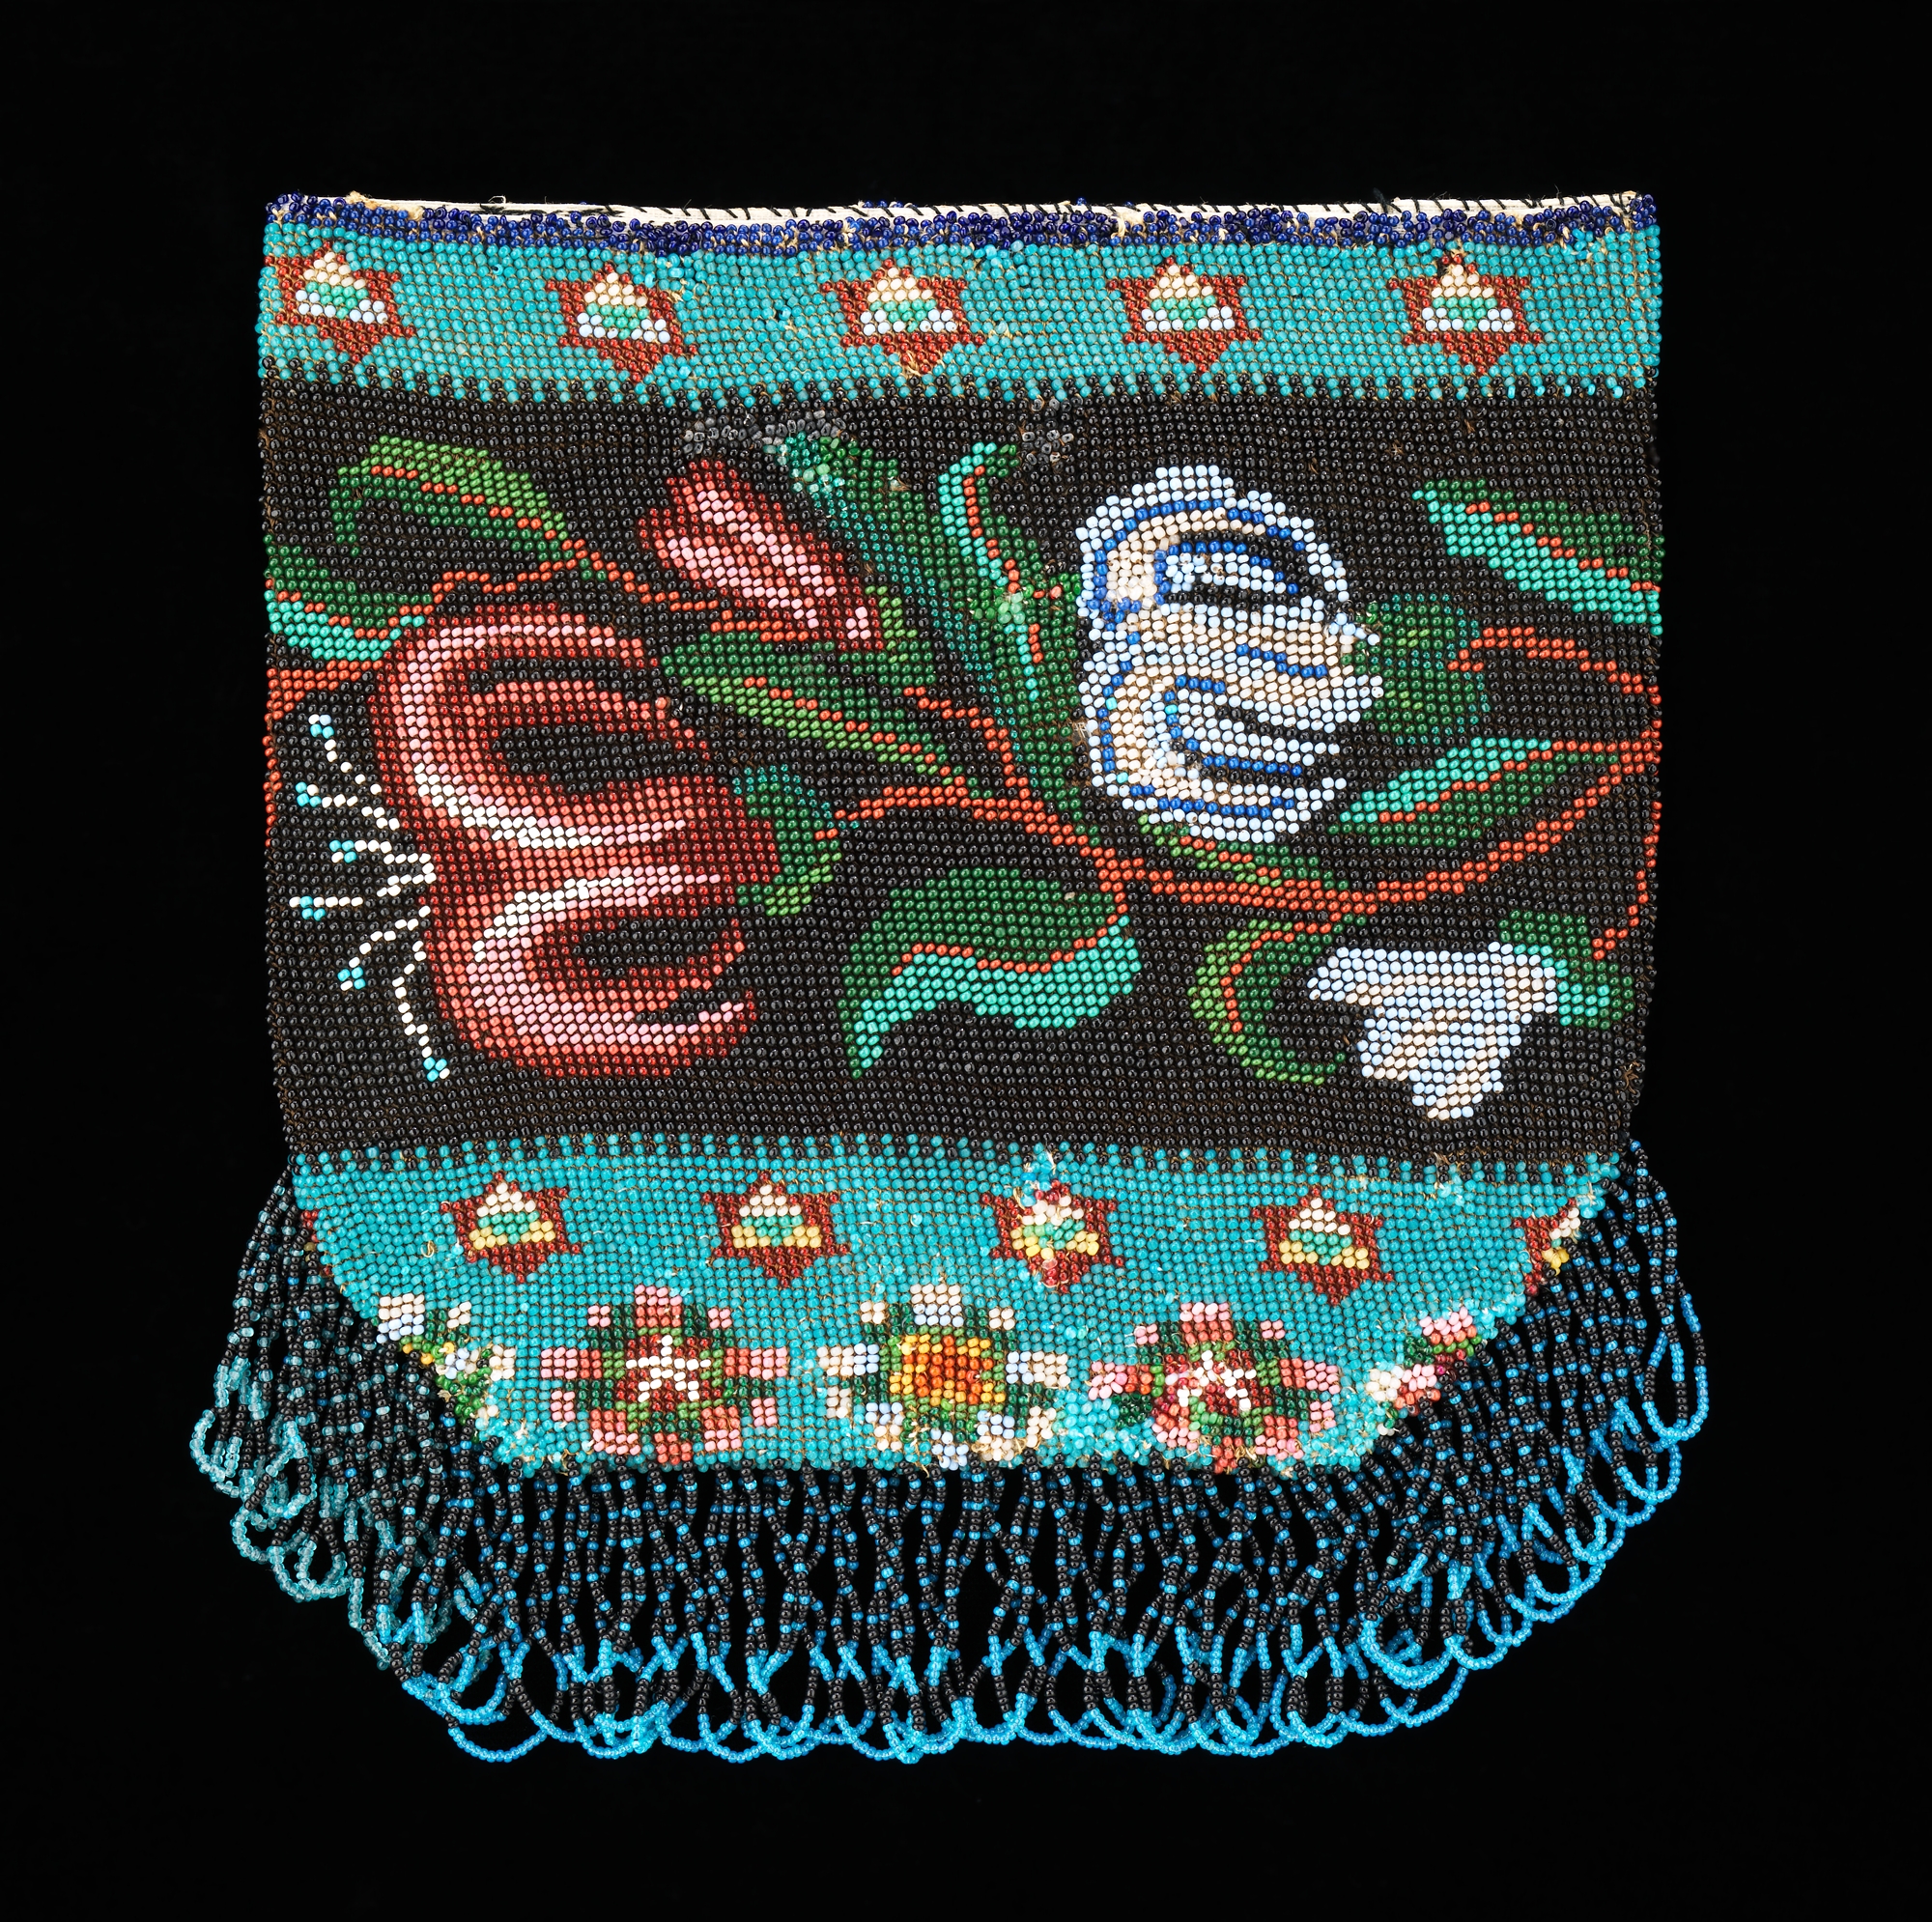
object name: pouch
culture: american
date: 1876-1900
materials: glass, linen